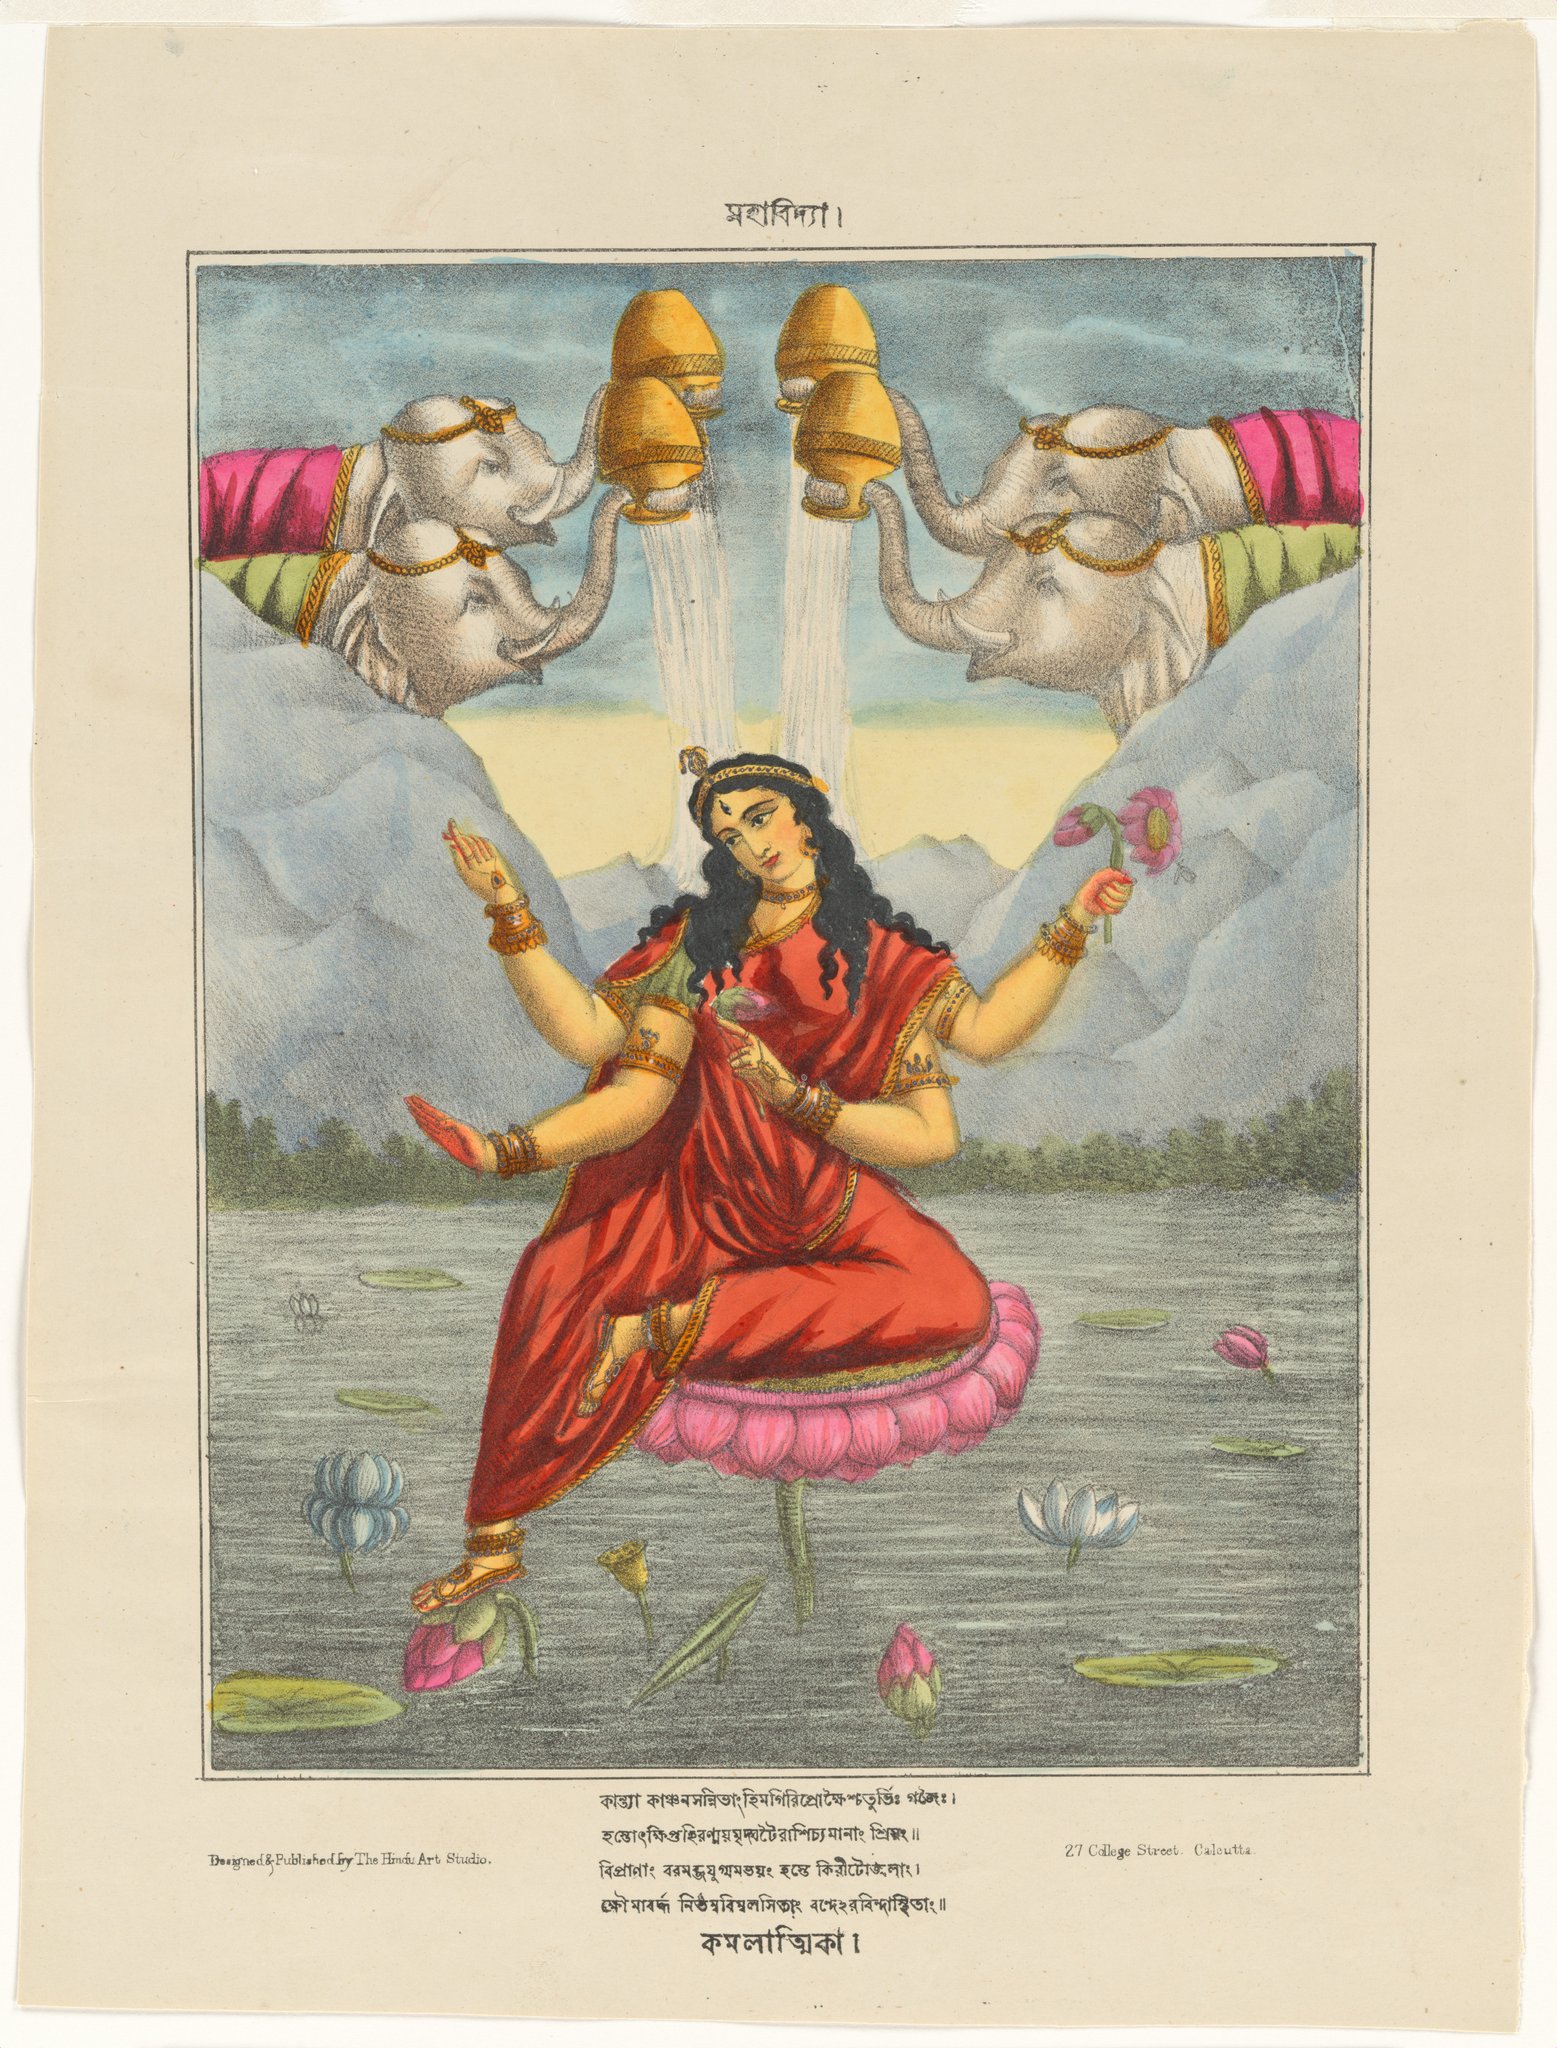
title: Goddess Kamalatmika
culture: west bengali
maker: the hindu art studio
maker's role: artist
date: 1880-1885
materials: glaze, watercolor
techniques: hand coloring, lithograph, printing